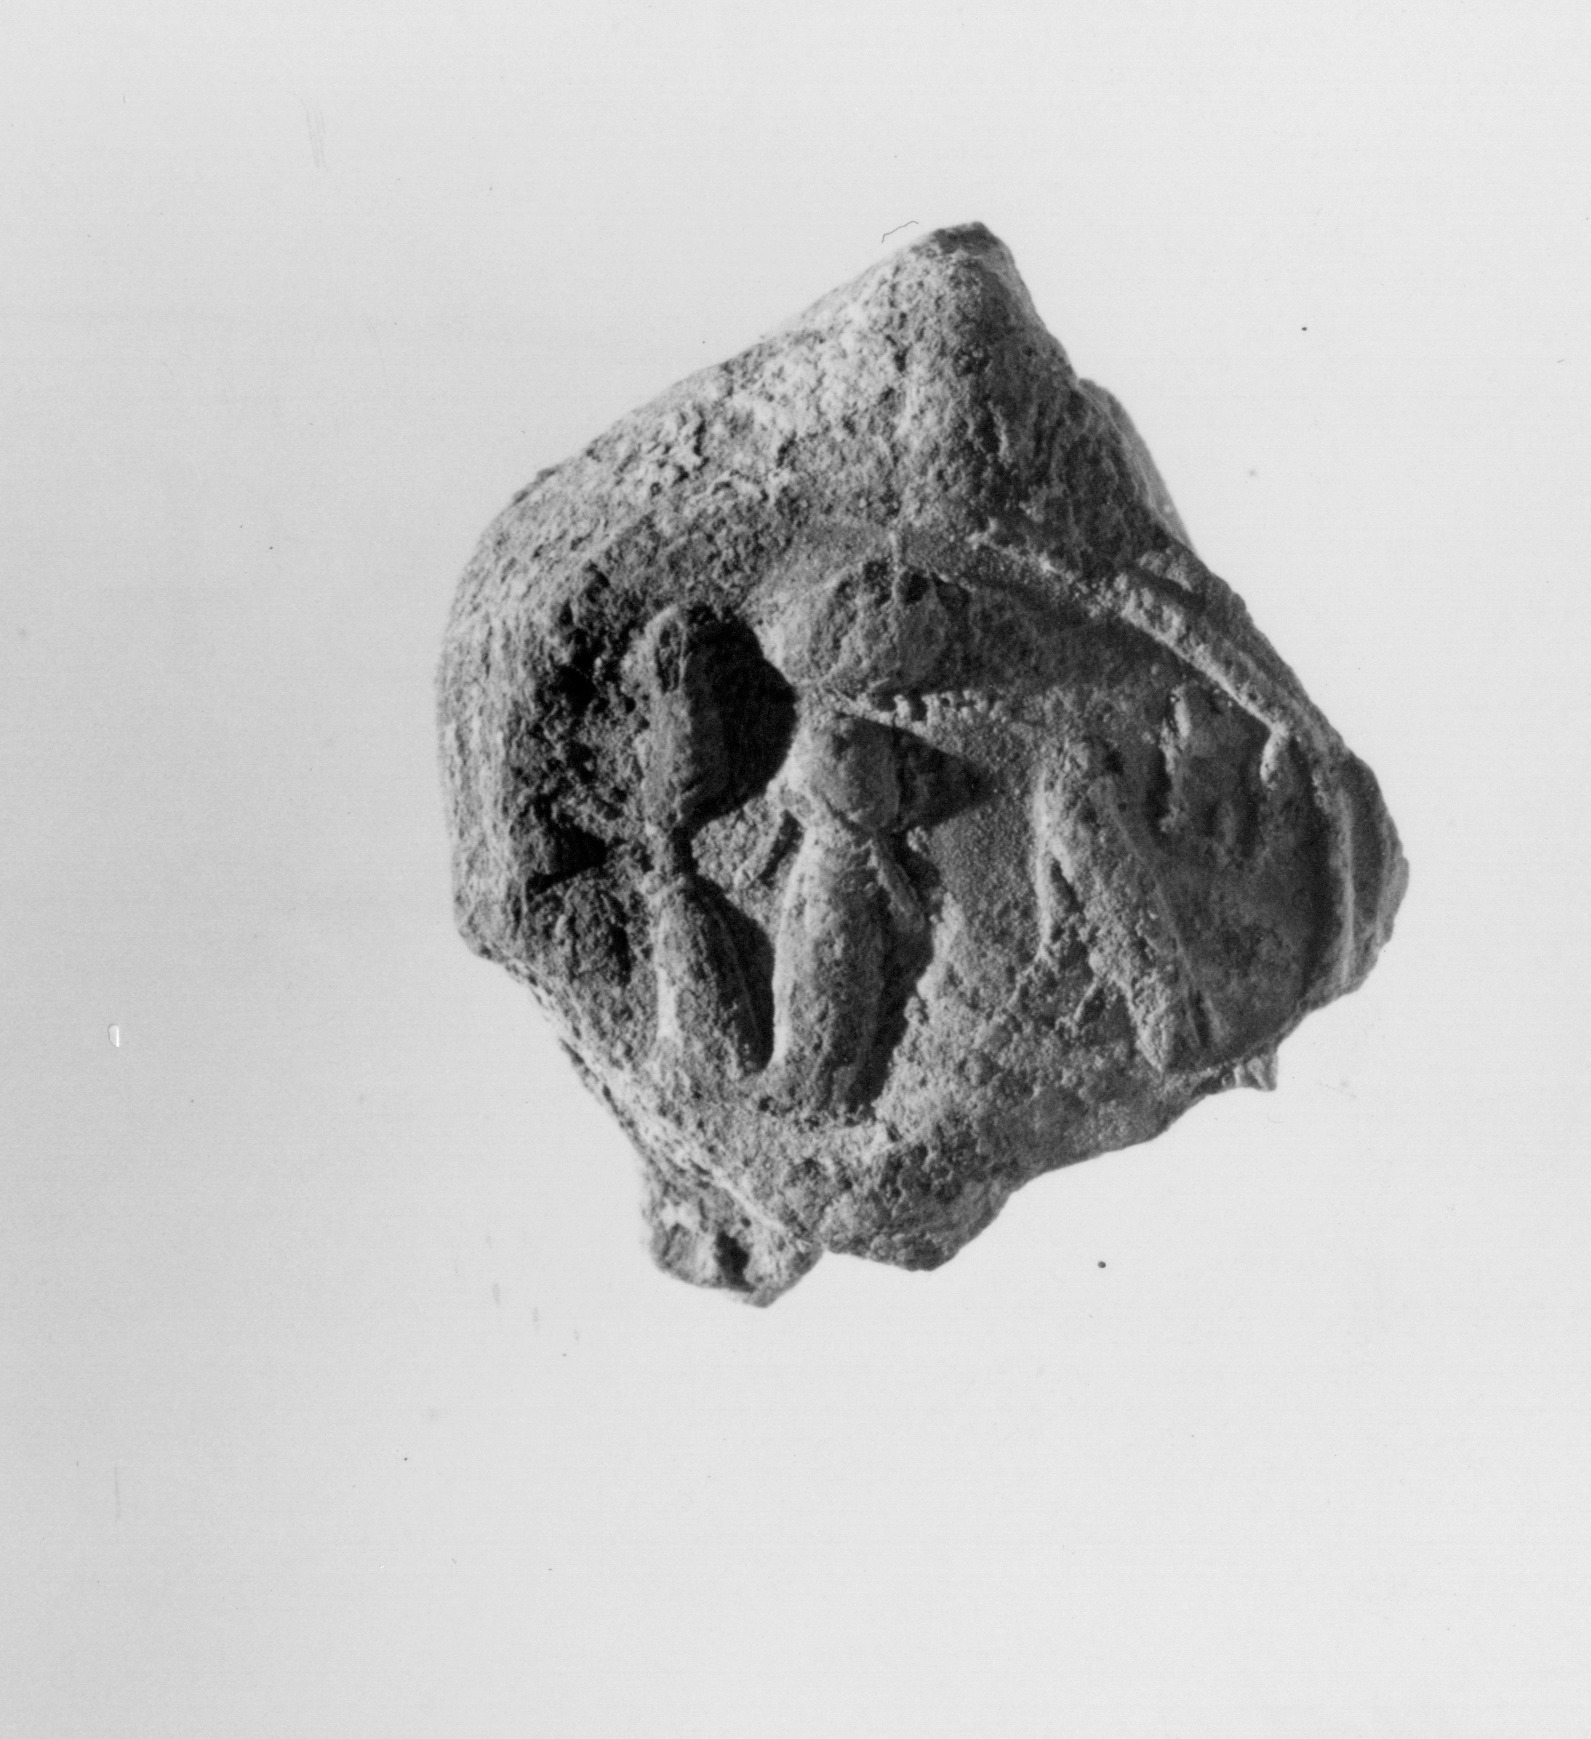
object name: sealing, nebmaatre, amenhotep iii, lower egypt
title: Document Sealing With the Throne Name of Amenhotep III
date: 1390-1352 BCE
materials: mud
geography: egypt